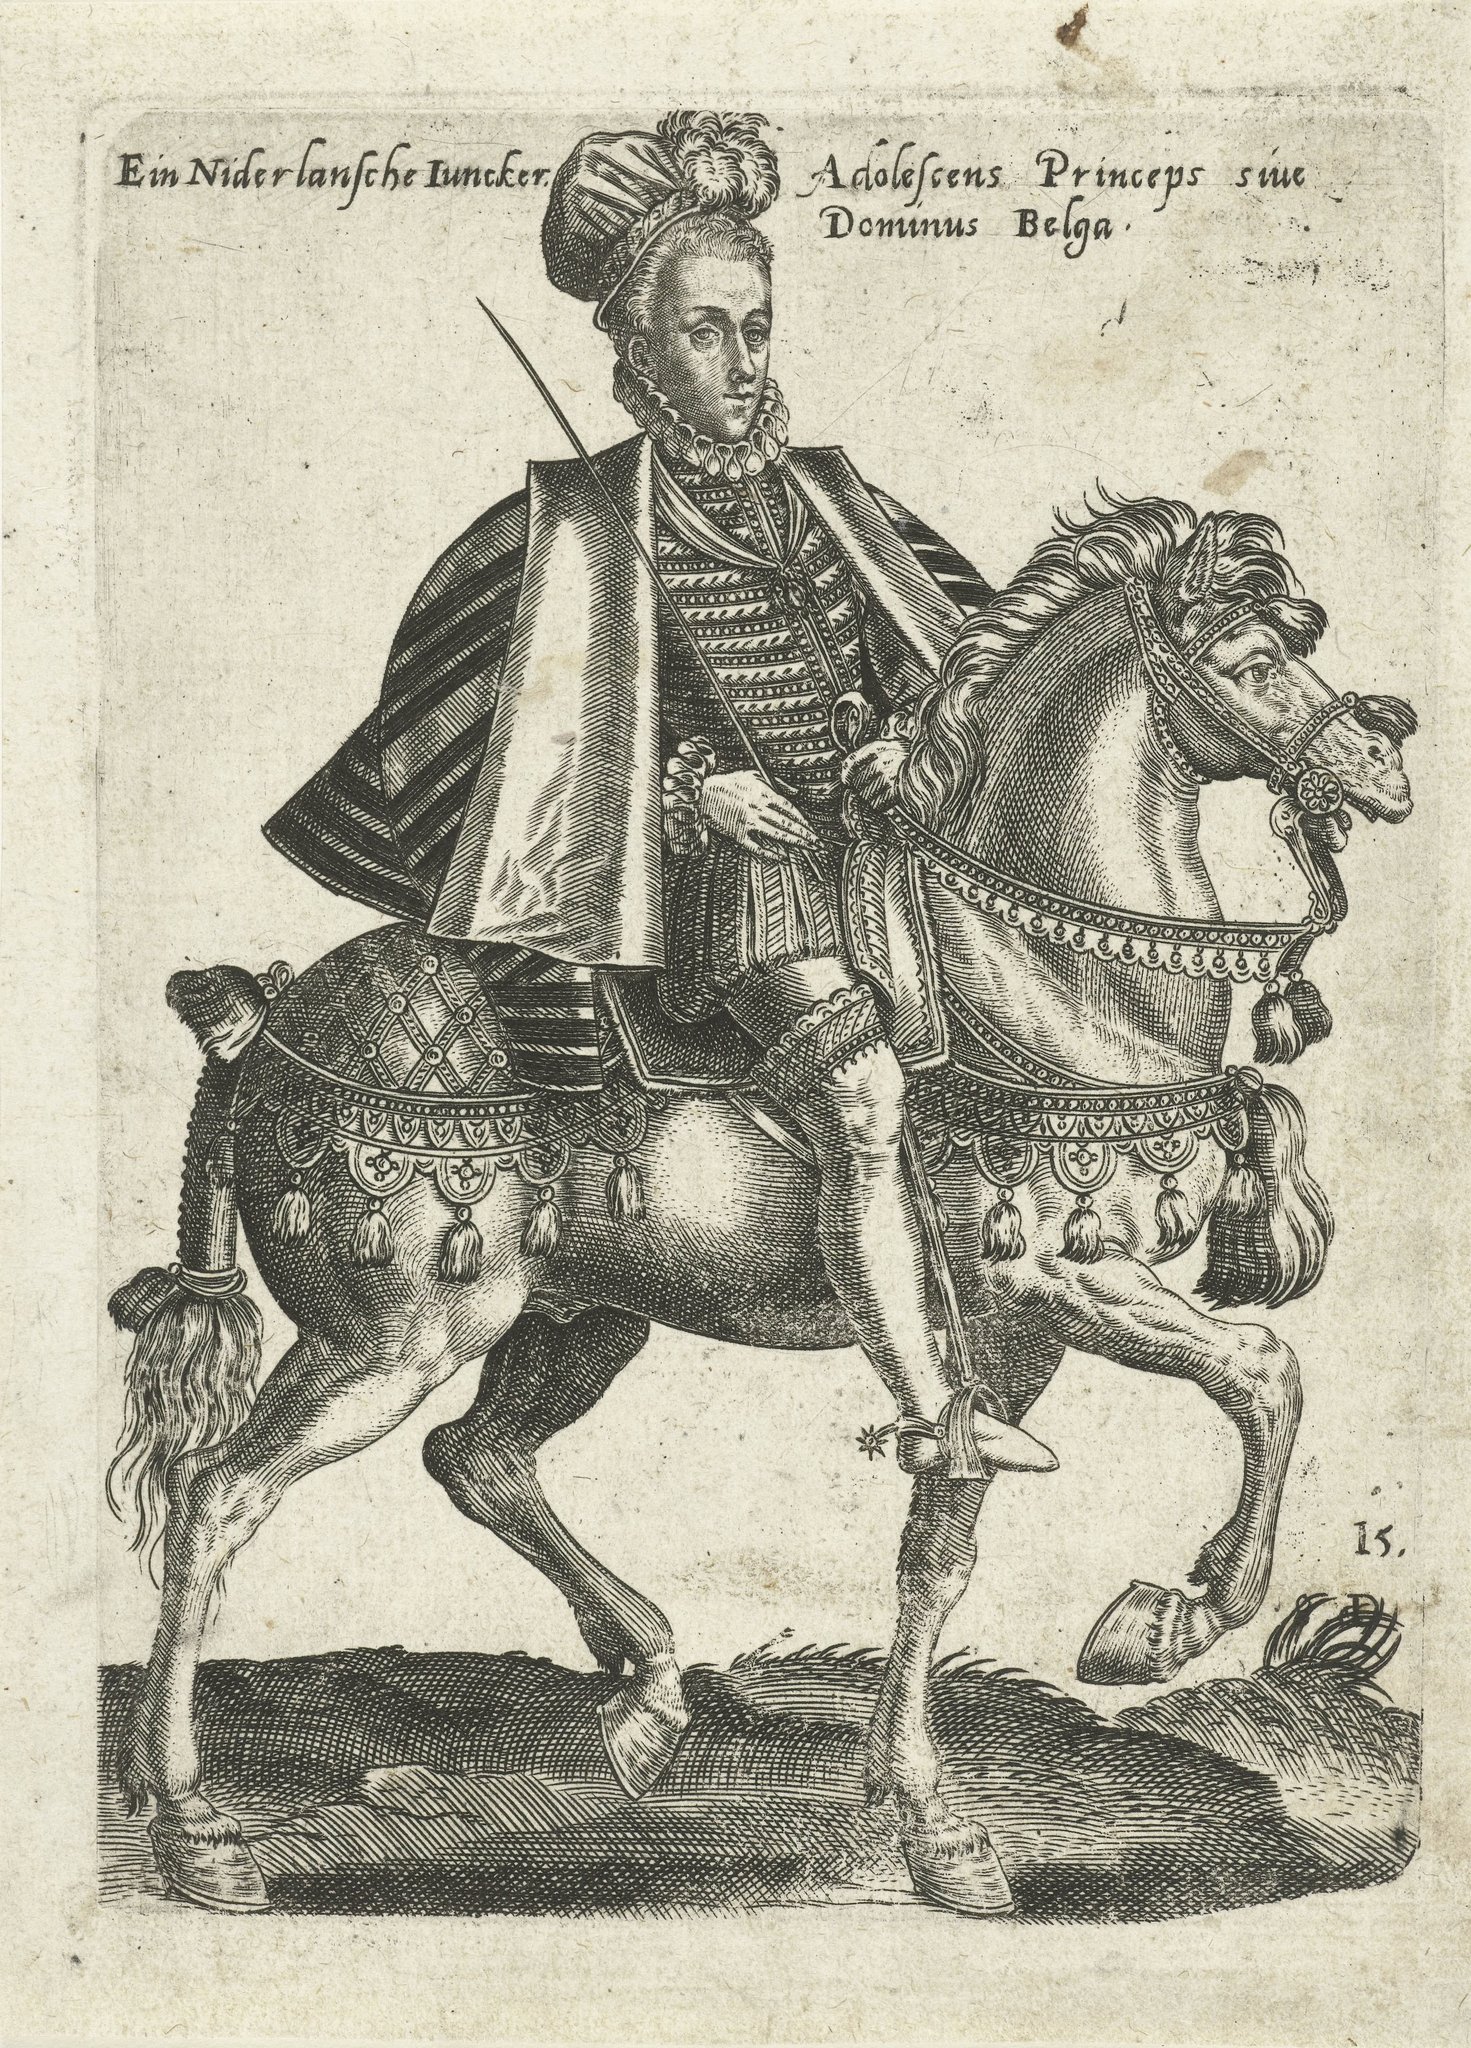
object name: costume print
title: Nederlandse jonker te paard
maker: abraham de bruyn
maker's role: print maker, publisher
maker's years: 1540-1587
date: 1577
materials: paper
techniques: engraving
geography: cologne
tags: warfare; military affairs (+ cavalry, horsemen), folk costume, regional costume, europeans (with name), feudal lord, whip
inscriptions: collector's mark: Lugt 2228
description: Prent oorspronkelijk verschenen in 'Equitum descripcio, quomodo equestres copie, nostra hac aetate, in sua armatura, per cunttas, videlicet Europae, Asiae et Affrice, nationes in re militare sese habent nunc primum', Keulen 1577.